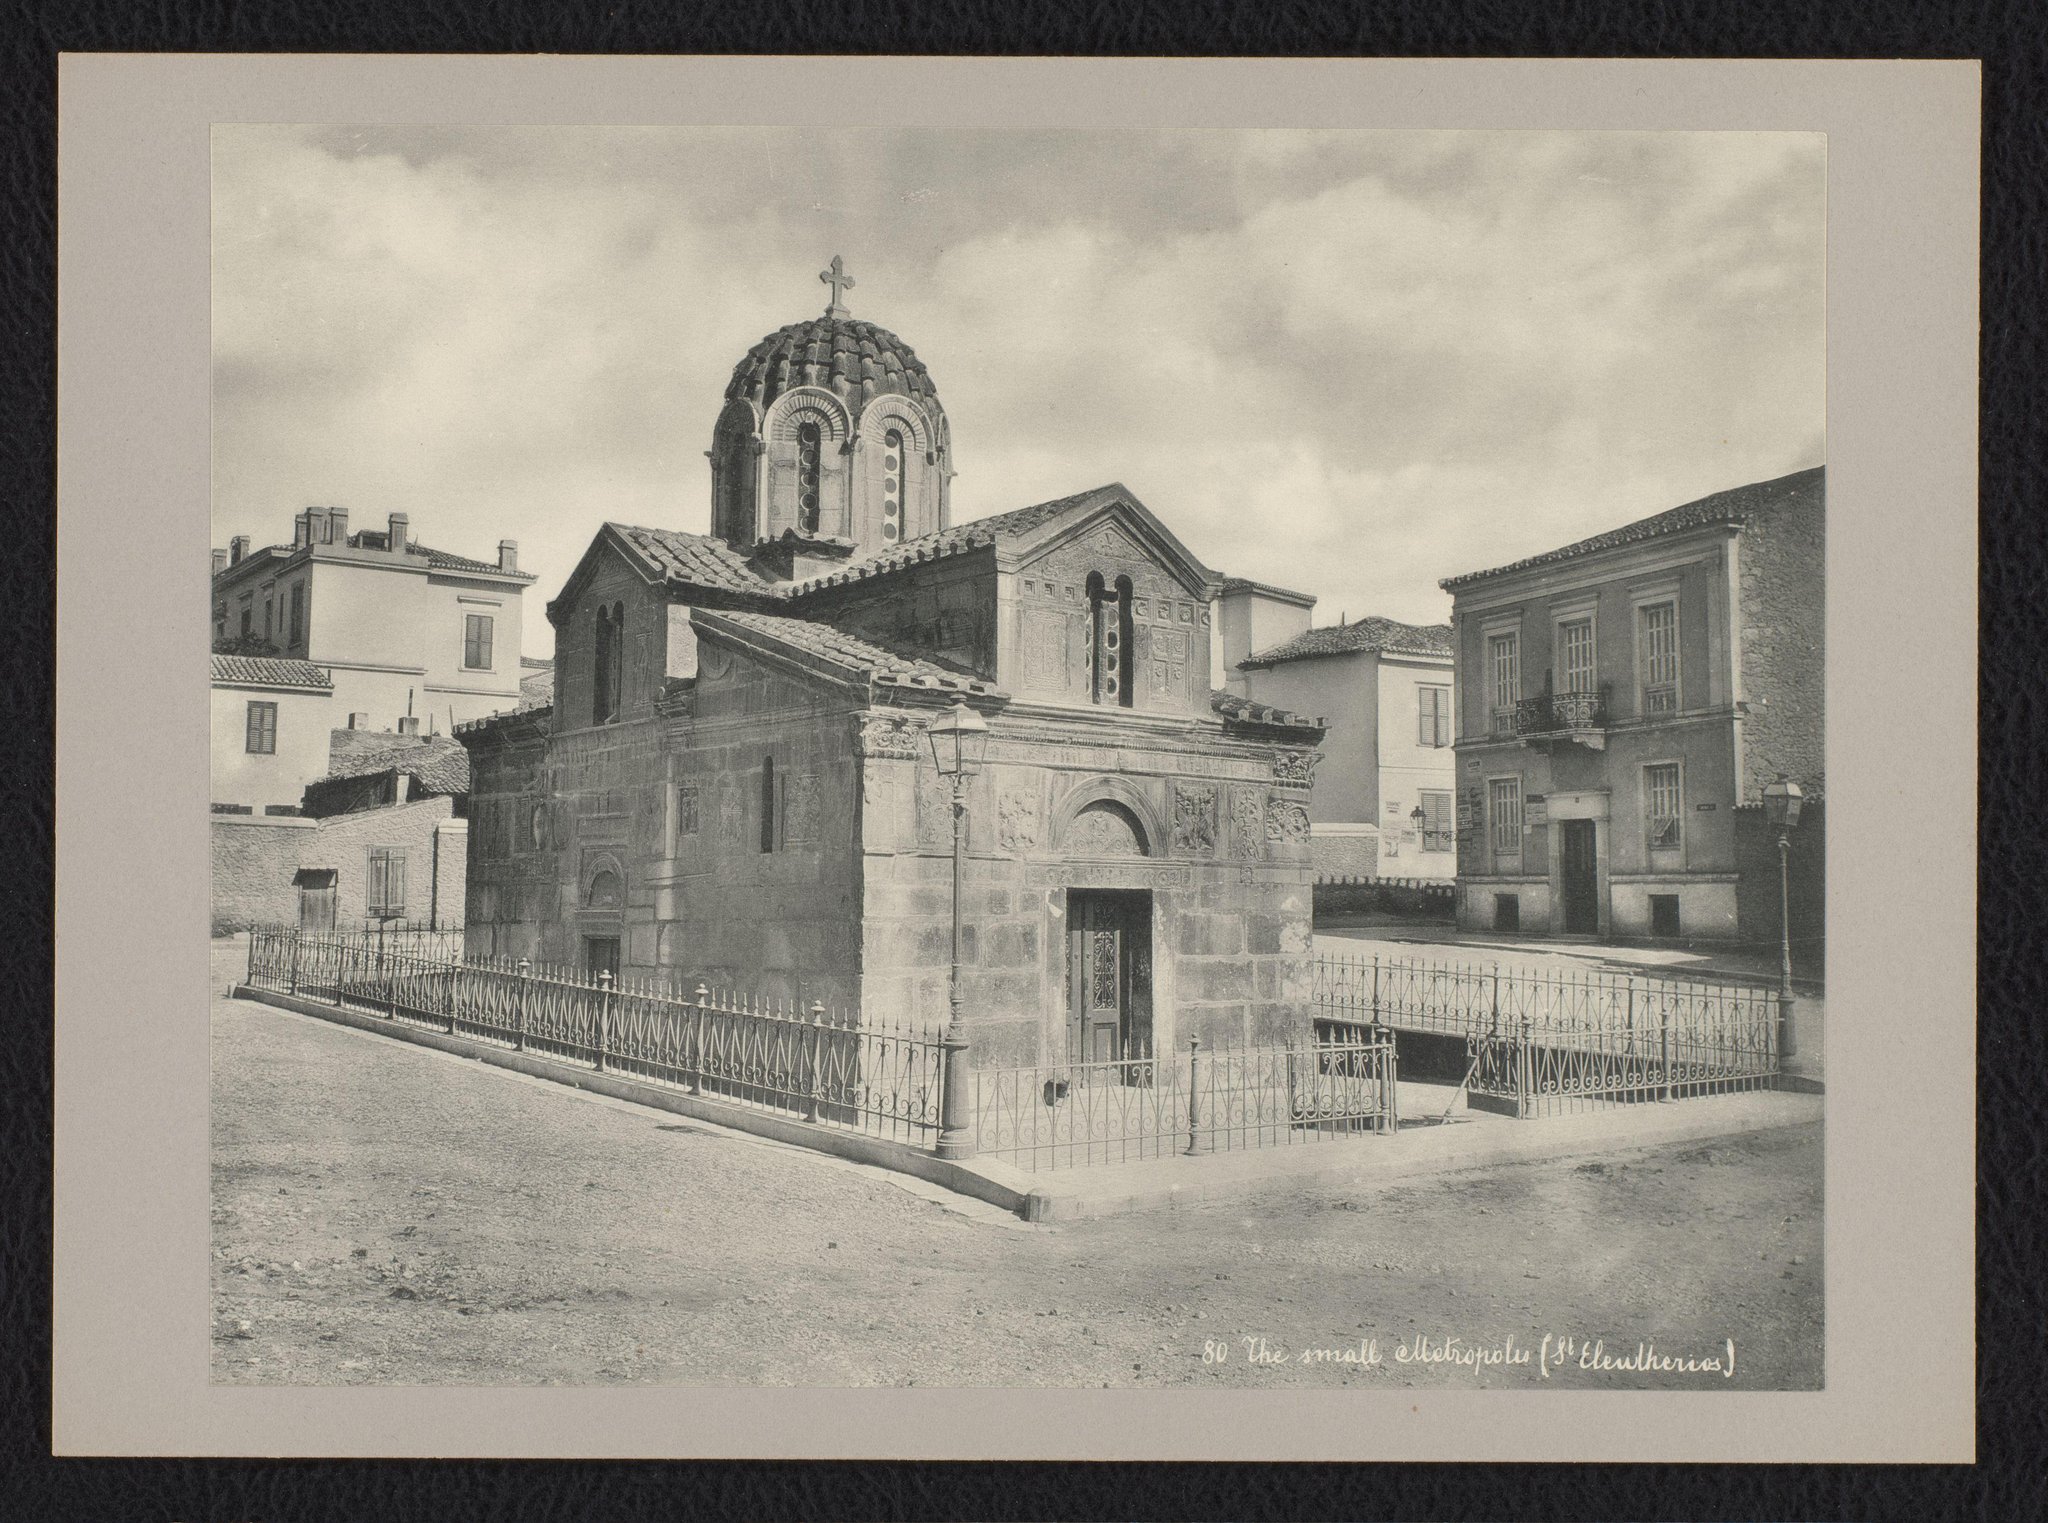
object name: photograph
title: Kleine Metropolis (Heilige Eleutherios)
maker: Anonymous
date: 1895-1915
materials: cardboard, paper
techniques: photograph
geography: athens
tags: athene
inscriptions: annotation: ‘29. De oude kathedraal te Athene.’